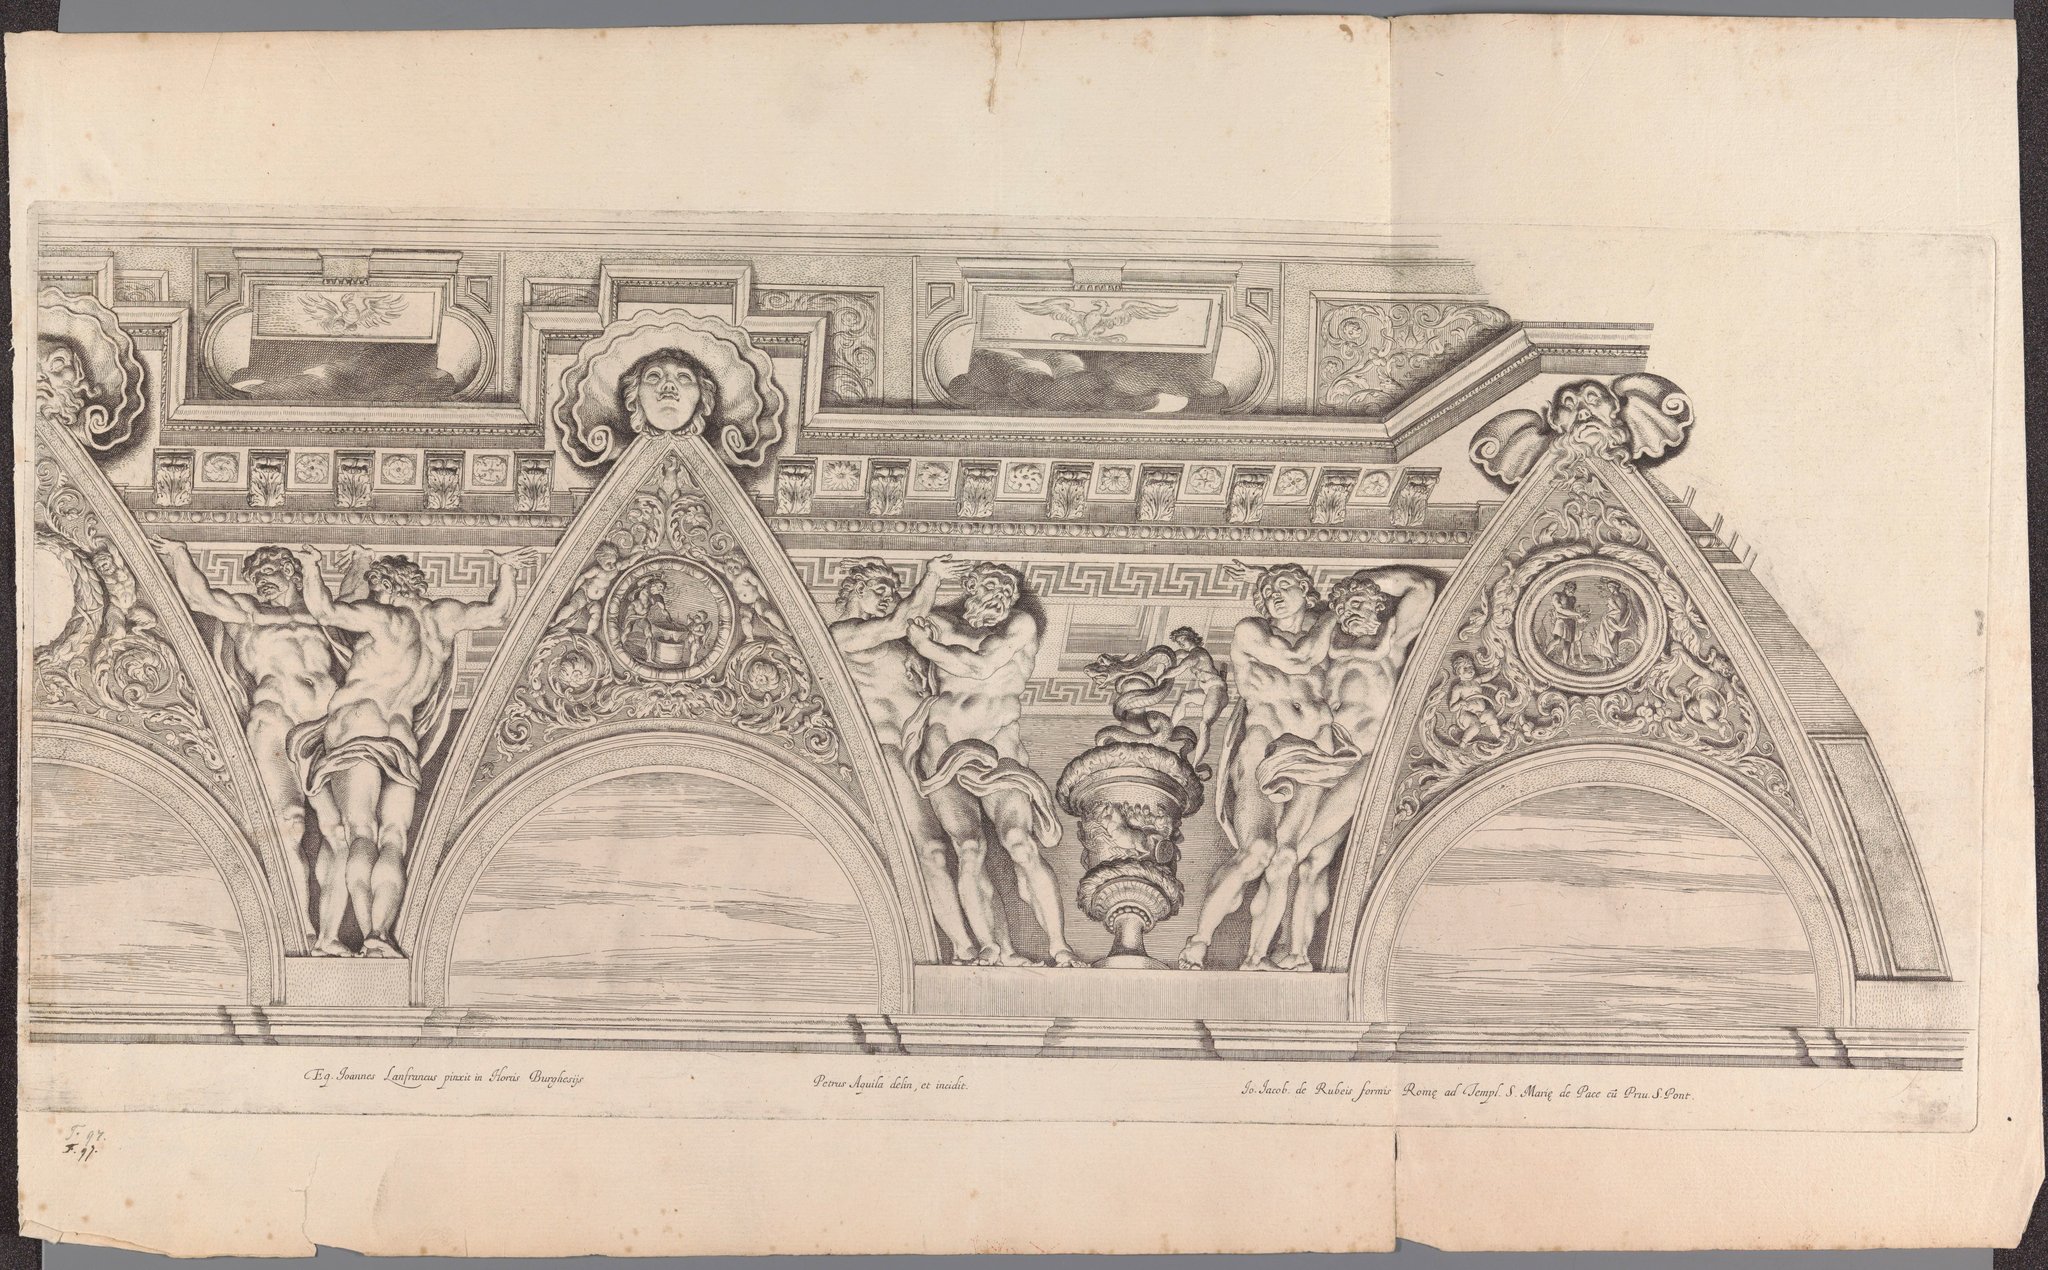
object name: print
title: Deorum concilium in Pinciis Burghesianis hortis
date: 1656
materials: paper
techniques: engraving, etching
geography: rome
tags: ornaments ~ art, the (nude) human figure; 'corpo humano' (ripa)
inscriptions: number: ‘125/ 136’, collector's mark: Lugt 11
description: Titelprent bij een reeks van 9 prenten door Pietro Aquila naar de plafondschildering 'De bijeenkomst van de Goden' door Giovanni Lanfranco in de Villa Borghese. Deze prent maakte oorspronkelijk deel uit van liber nr. 22 van de Atlas van Rome, uit de collectie Hinloopen. In dit album waren een aantal prentreeksen naar bekende zeventiende eeuwse frescoseries bijeengebonden. In 1709 heeft Schijnvoet op last van de burgemeesters van Amsterdam de collectie herordend. De prenten uit liber 22 kwamen terrecht in Schijnvoet boek nr. 10. De laatst gedateerde reeks in het album is gedateerd 1691. Het album moet dus na deze datum gebonden zijn. De band is in de Rijksakademietijd uit elkaar gehaald. De marges van de prenten zijn bij het opbergen in het Rijksprentenkabinet vaak drastisch afgesneden. Van een aantal series waren de prenten teruggeslagen om in het album te passen. (Zie: Waals, Jan van der. De prentschat van Michiel Hinloopen. 's-Gravenhage: SDU uitgeverij, 1988, pp. 173-174.)